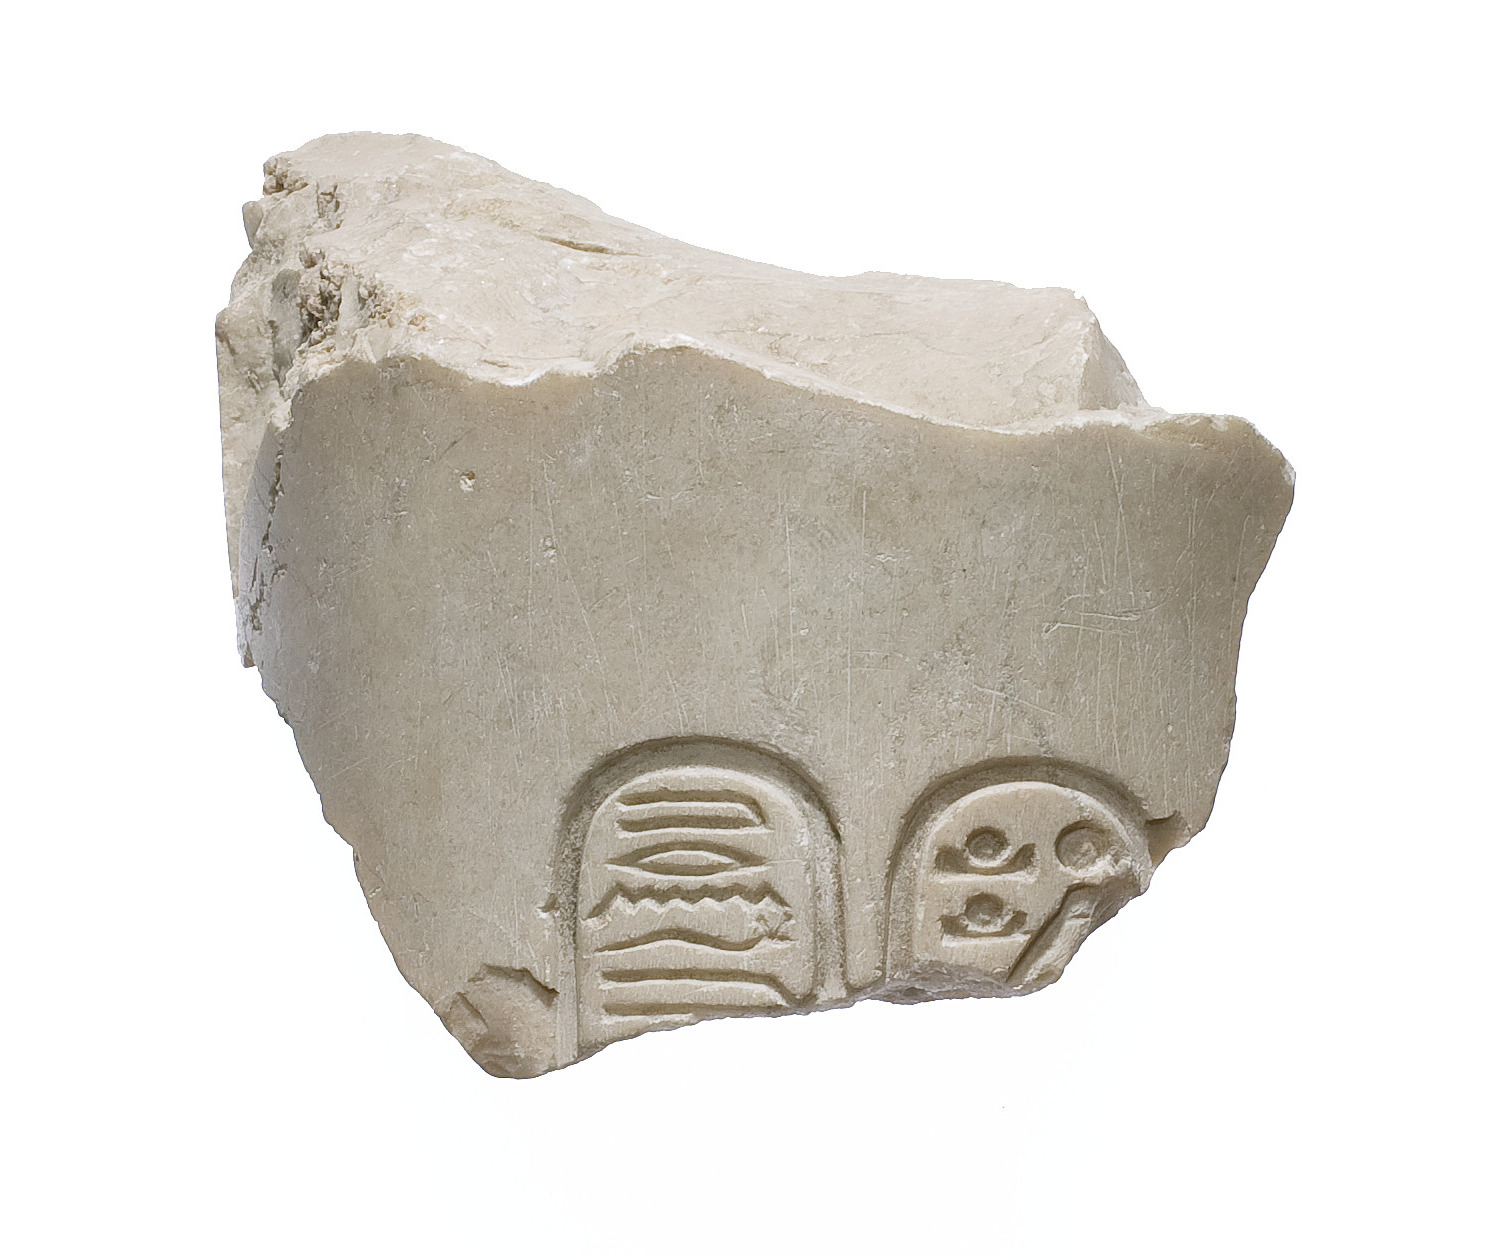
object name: arm at shoulder, aten cartouch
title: Arm, outside shoulder, Aten cartouches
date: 1353-1336 BCE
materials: limestone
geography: egypt